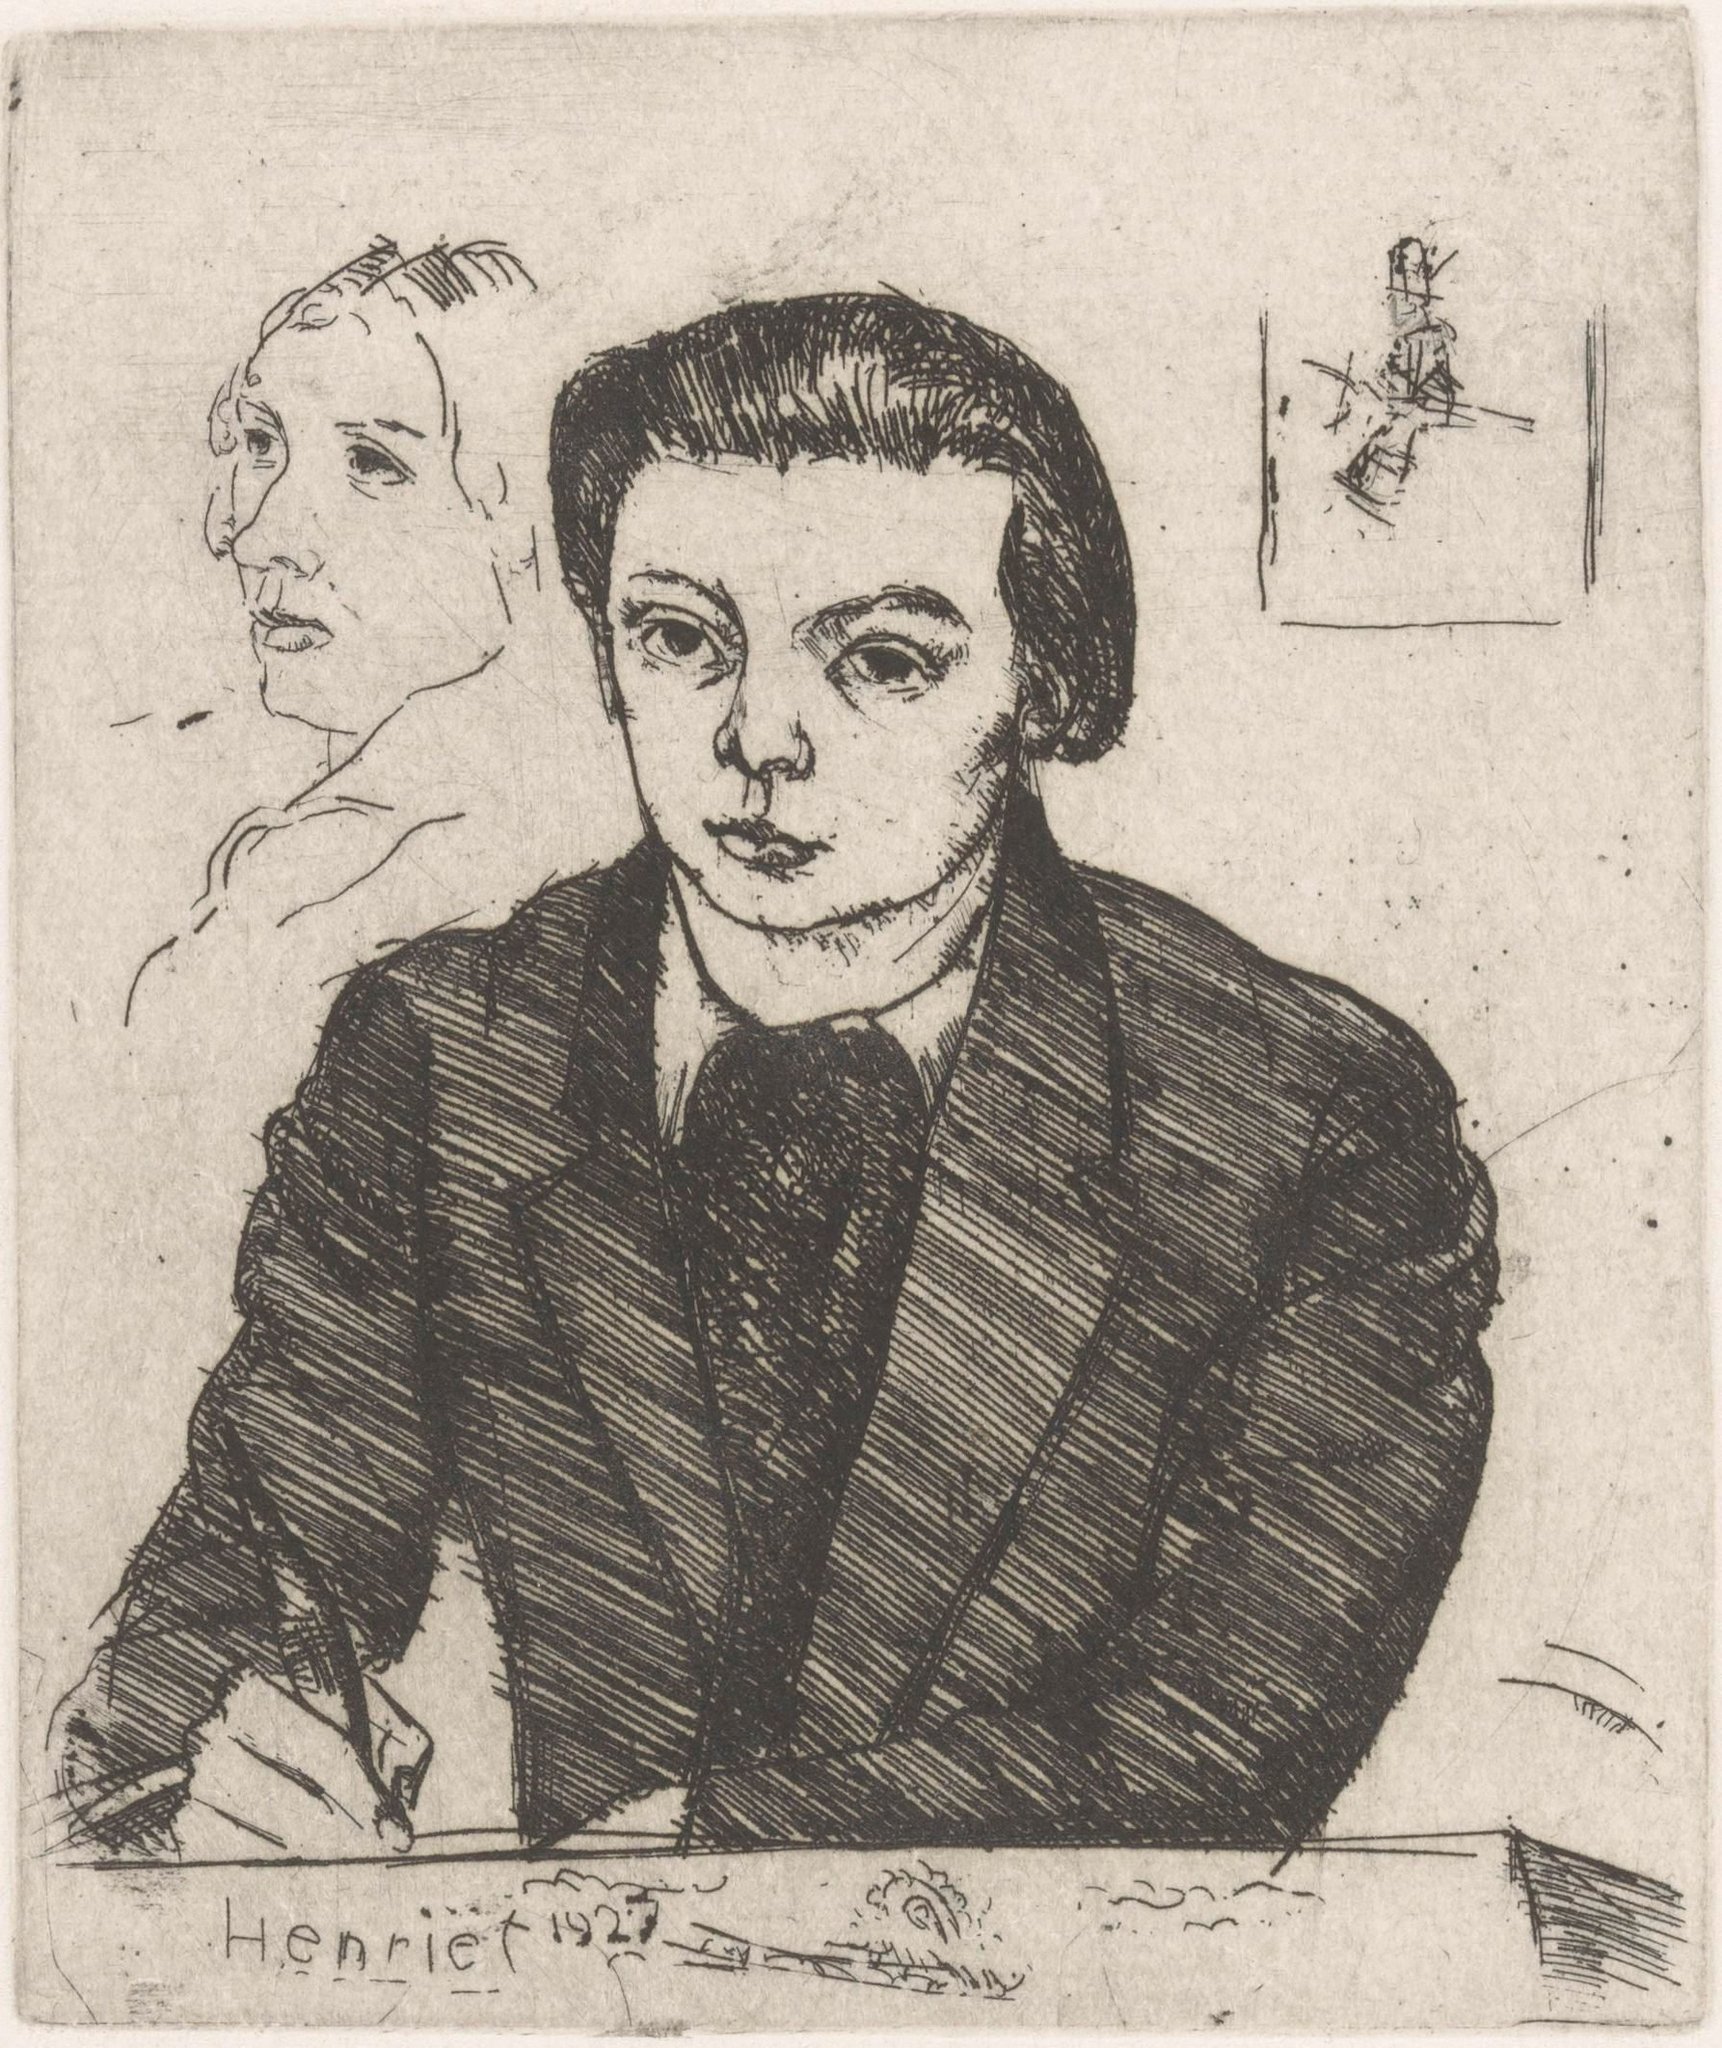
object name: print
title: Schrijvende jongeman, mogelijk een zelfportret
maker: henk henriët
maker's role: draughtsman, print maker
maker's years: 1903-1945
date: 1927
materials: paper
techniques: etching, intaglio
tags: handwriting, writing as activity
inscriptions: collector's mark: Lugt 2228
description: Links op de achtergrond het hoofd van een figuur.